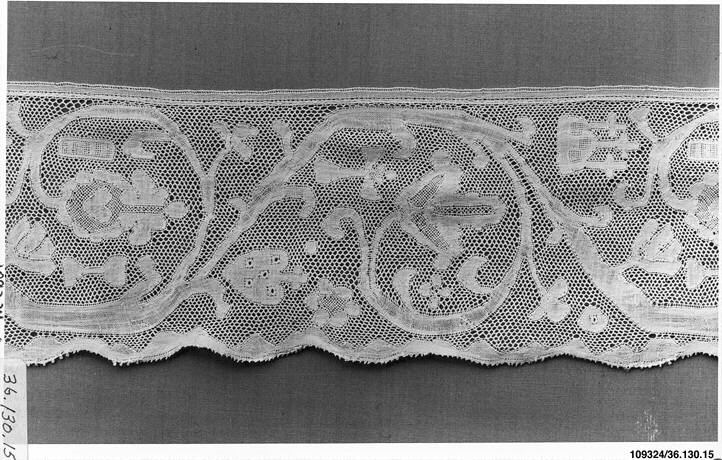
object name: border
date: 1601-1800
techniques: lace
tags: flowers,vines,cross